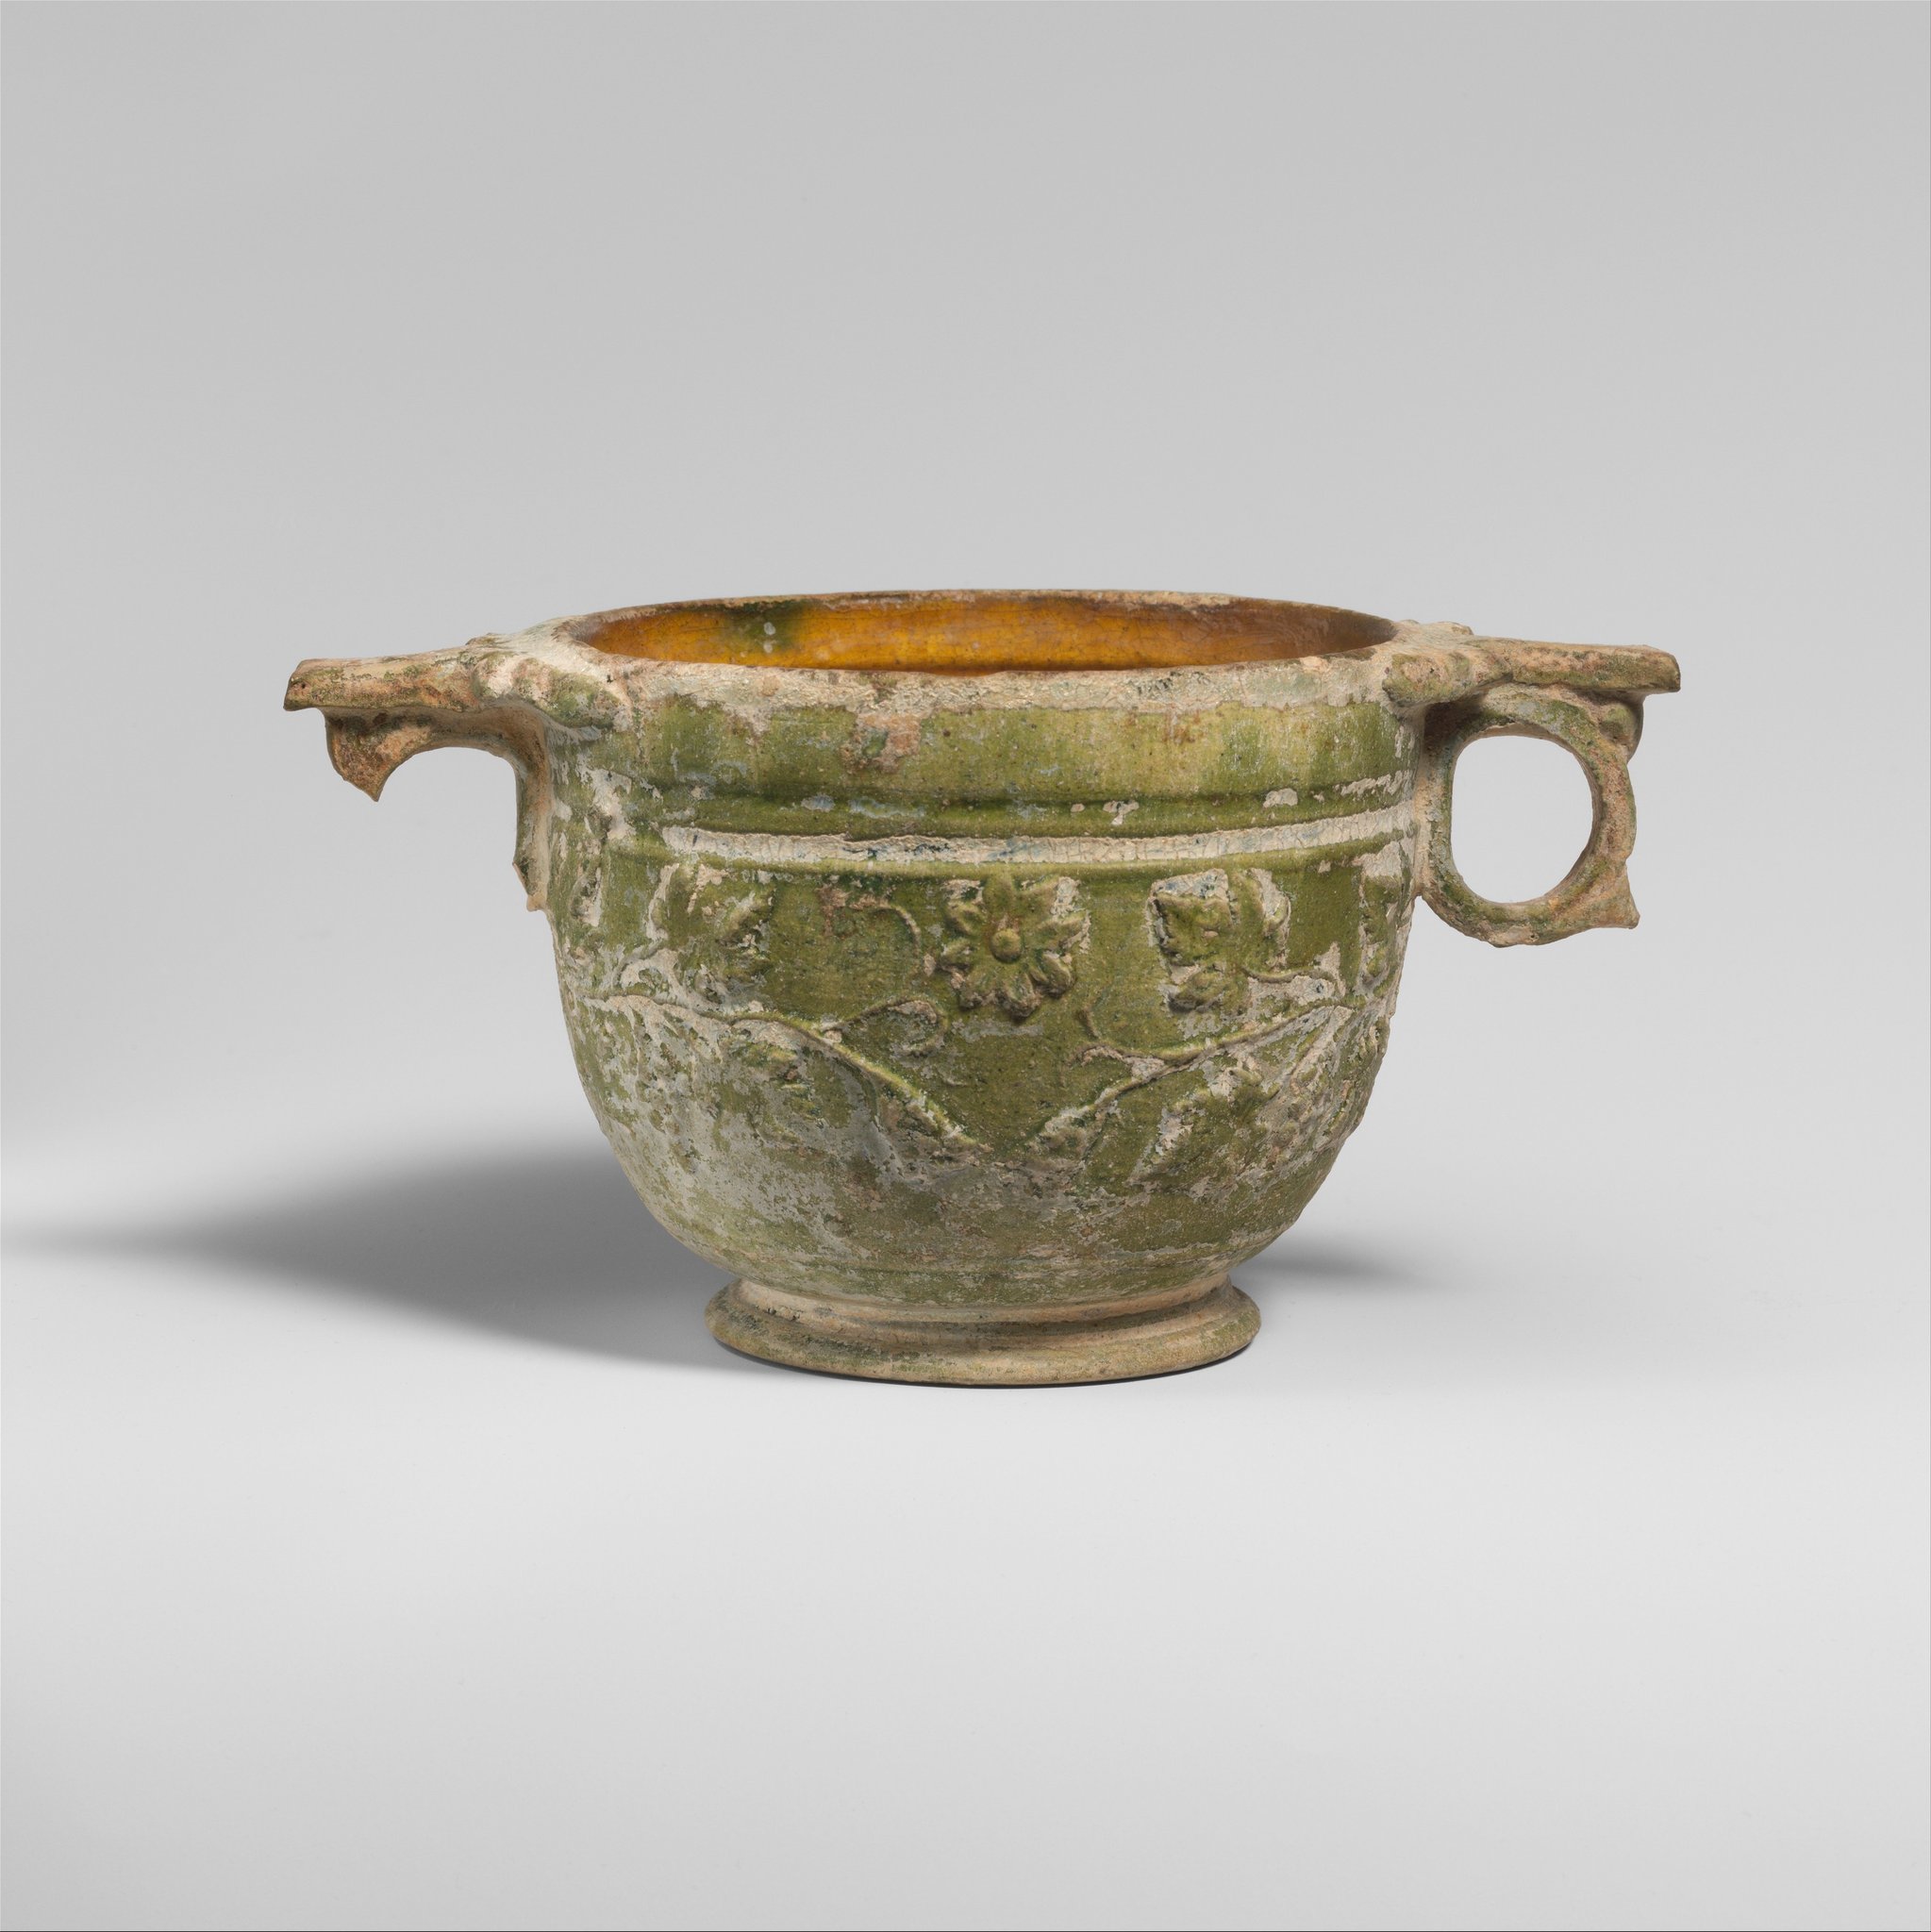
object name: scyphus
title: Terracotta lead-glazed scyphus (drinking cup)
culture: roman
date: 1-50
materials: terracotta